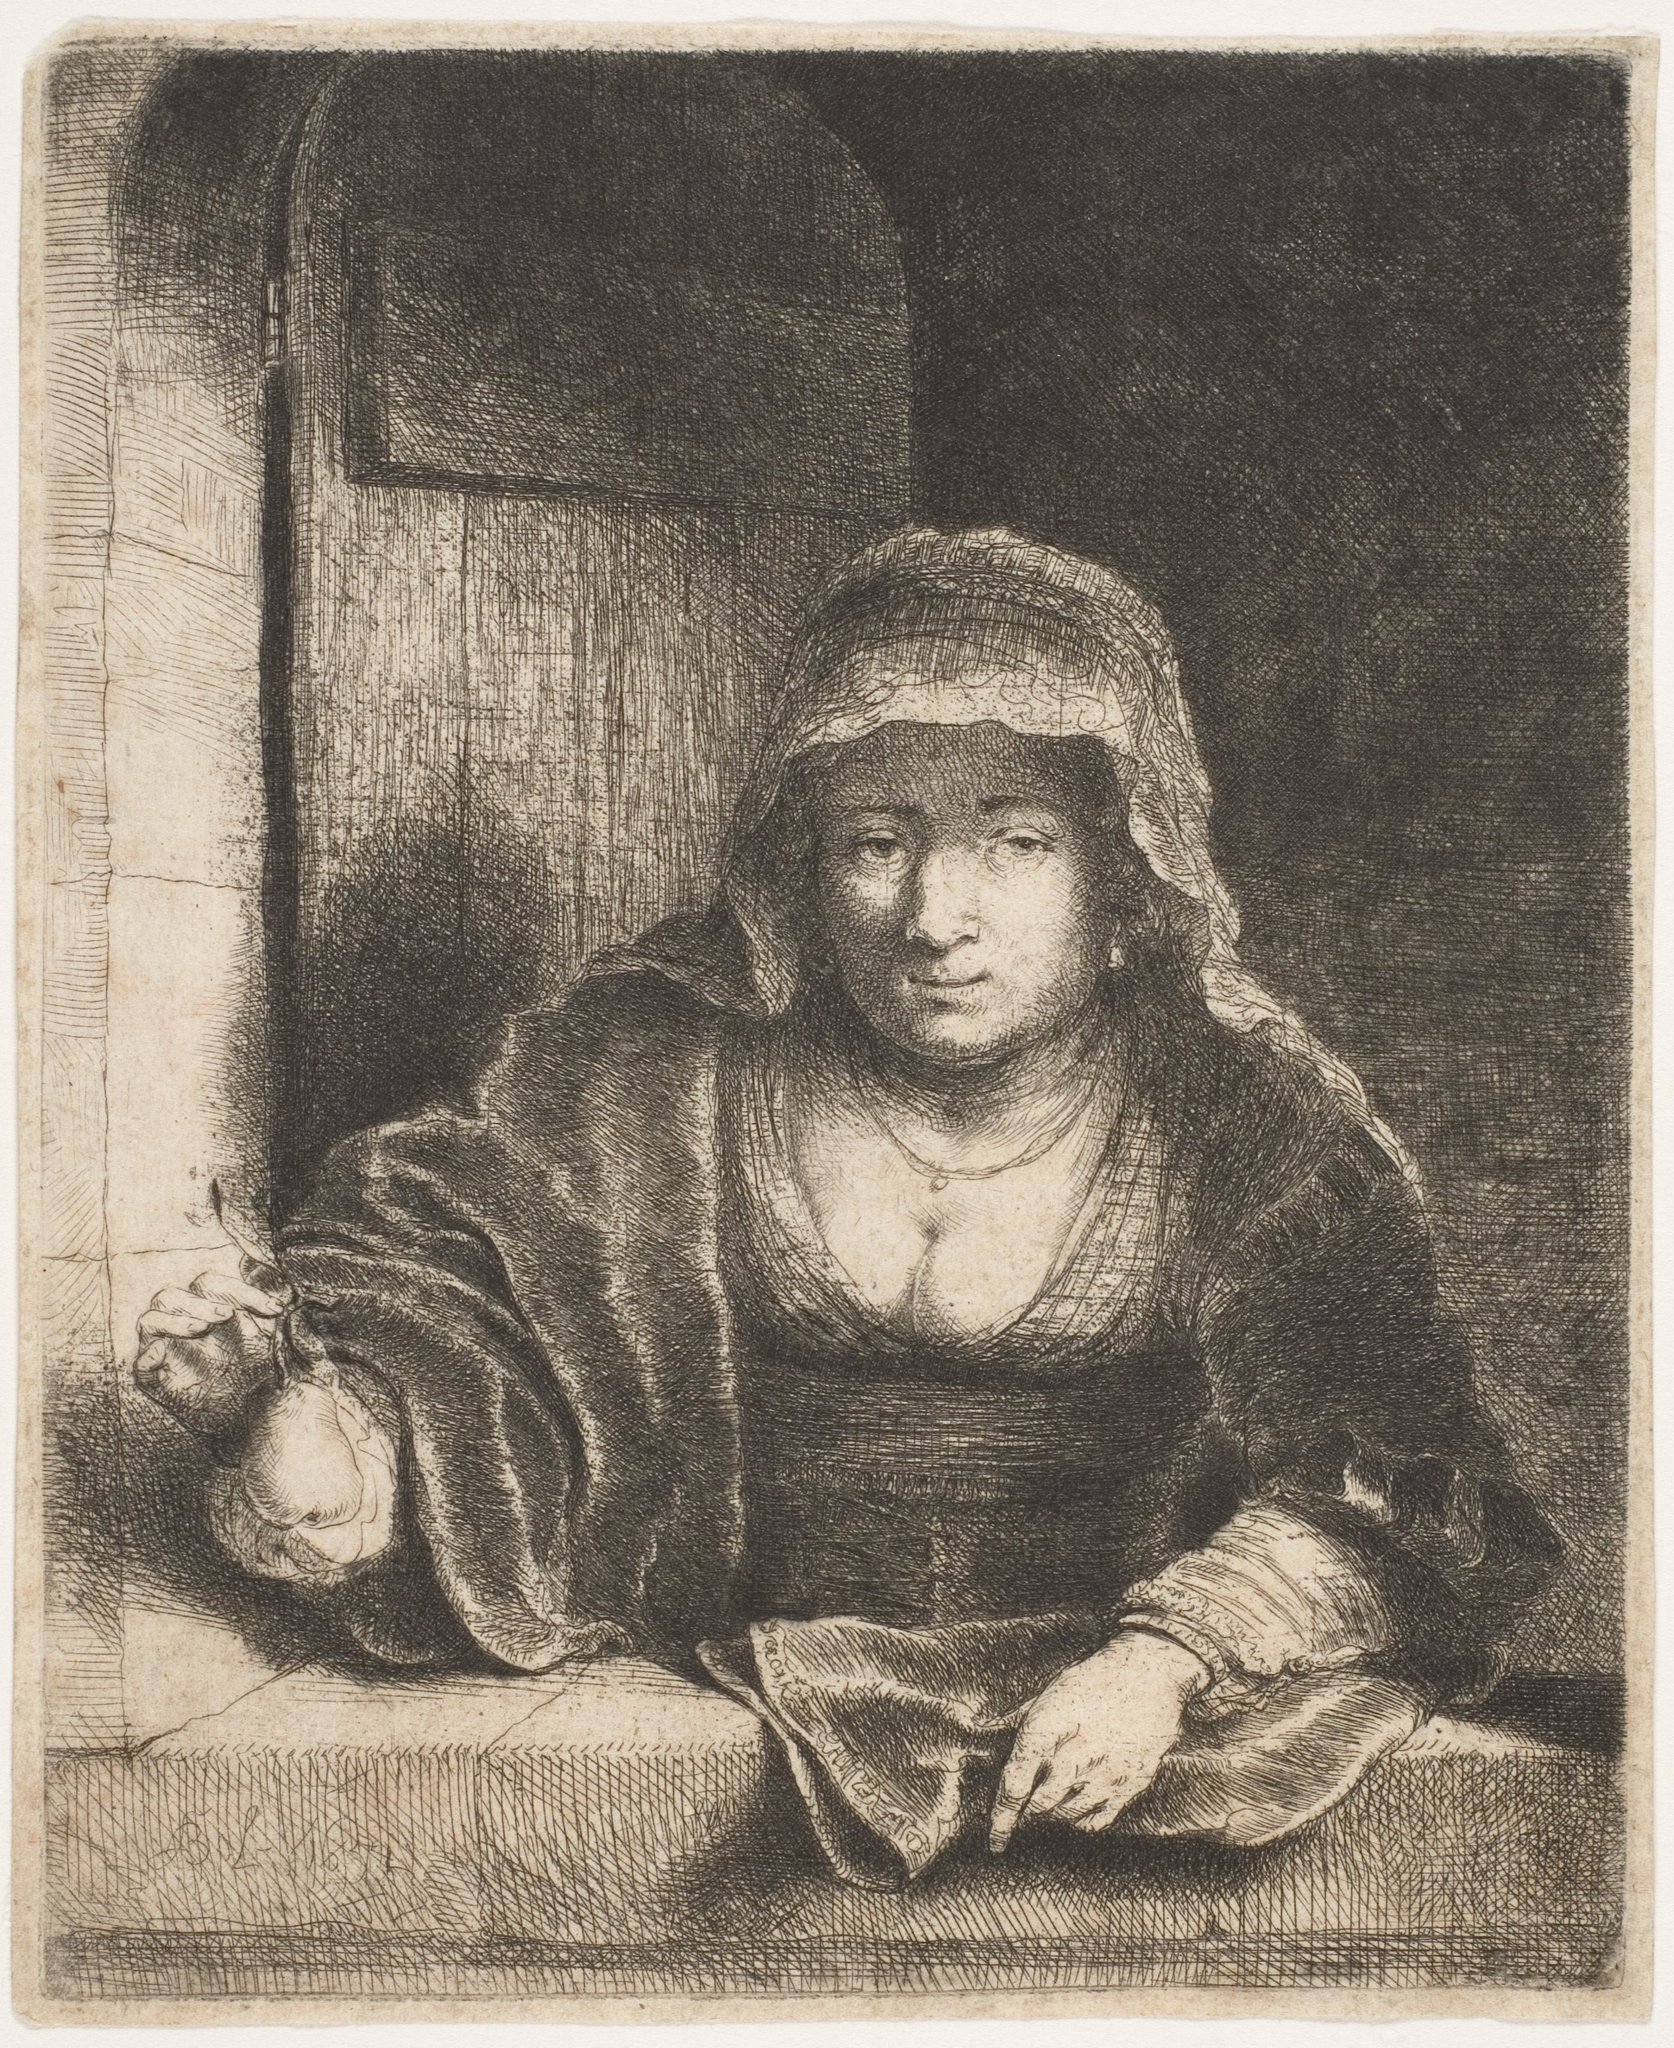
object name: print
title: Woman with a Pear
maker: ferdinand bol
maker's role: artist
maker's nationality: dutch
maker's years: 1616-1680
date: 1601-1700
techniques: etching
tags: pears,portraits,women